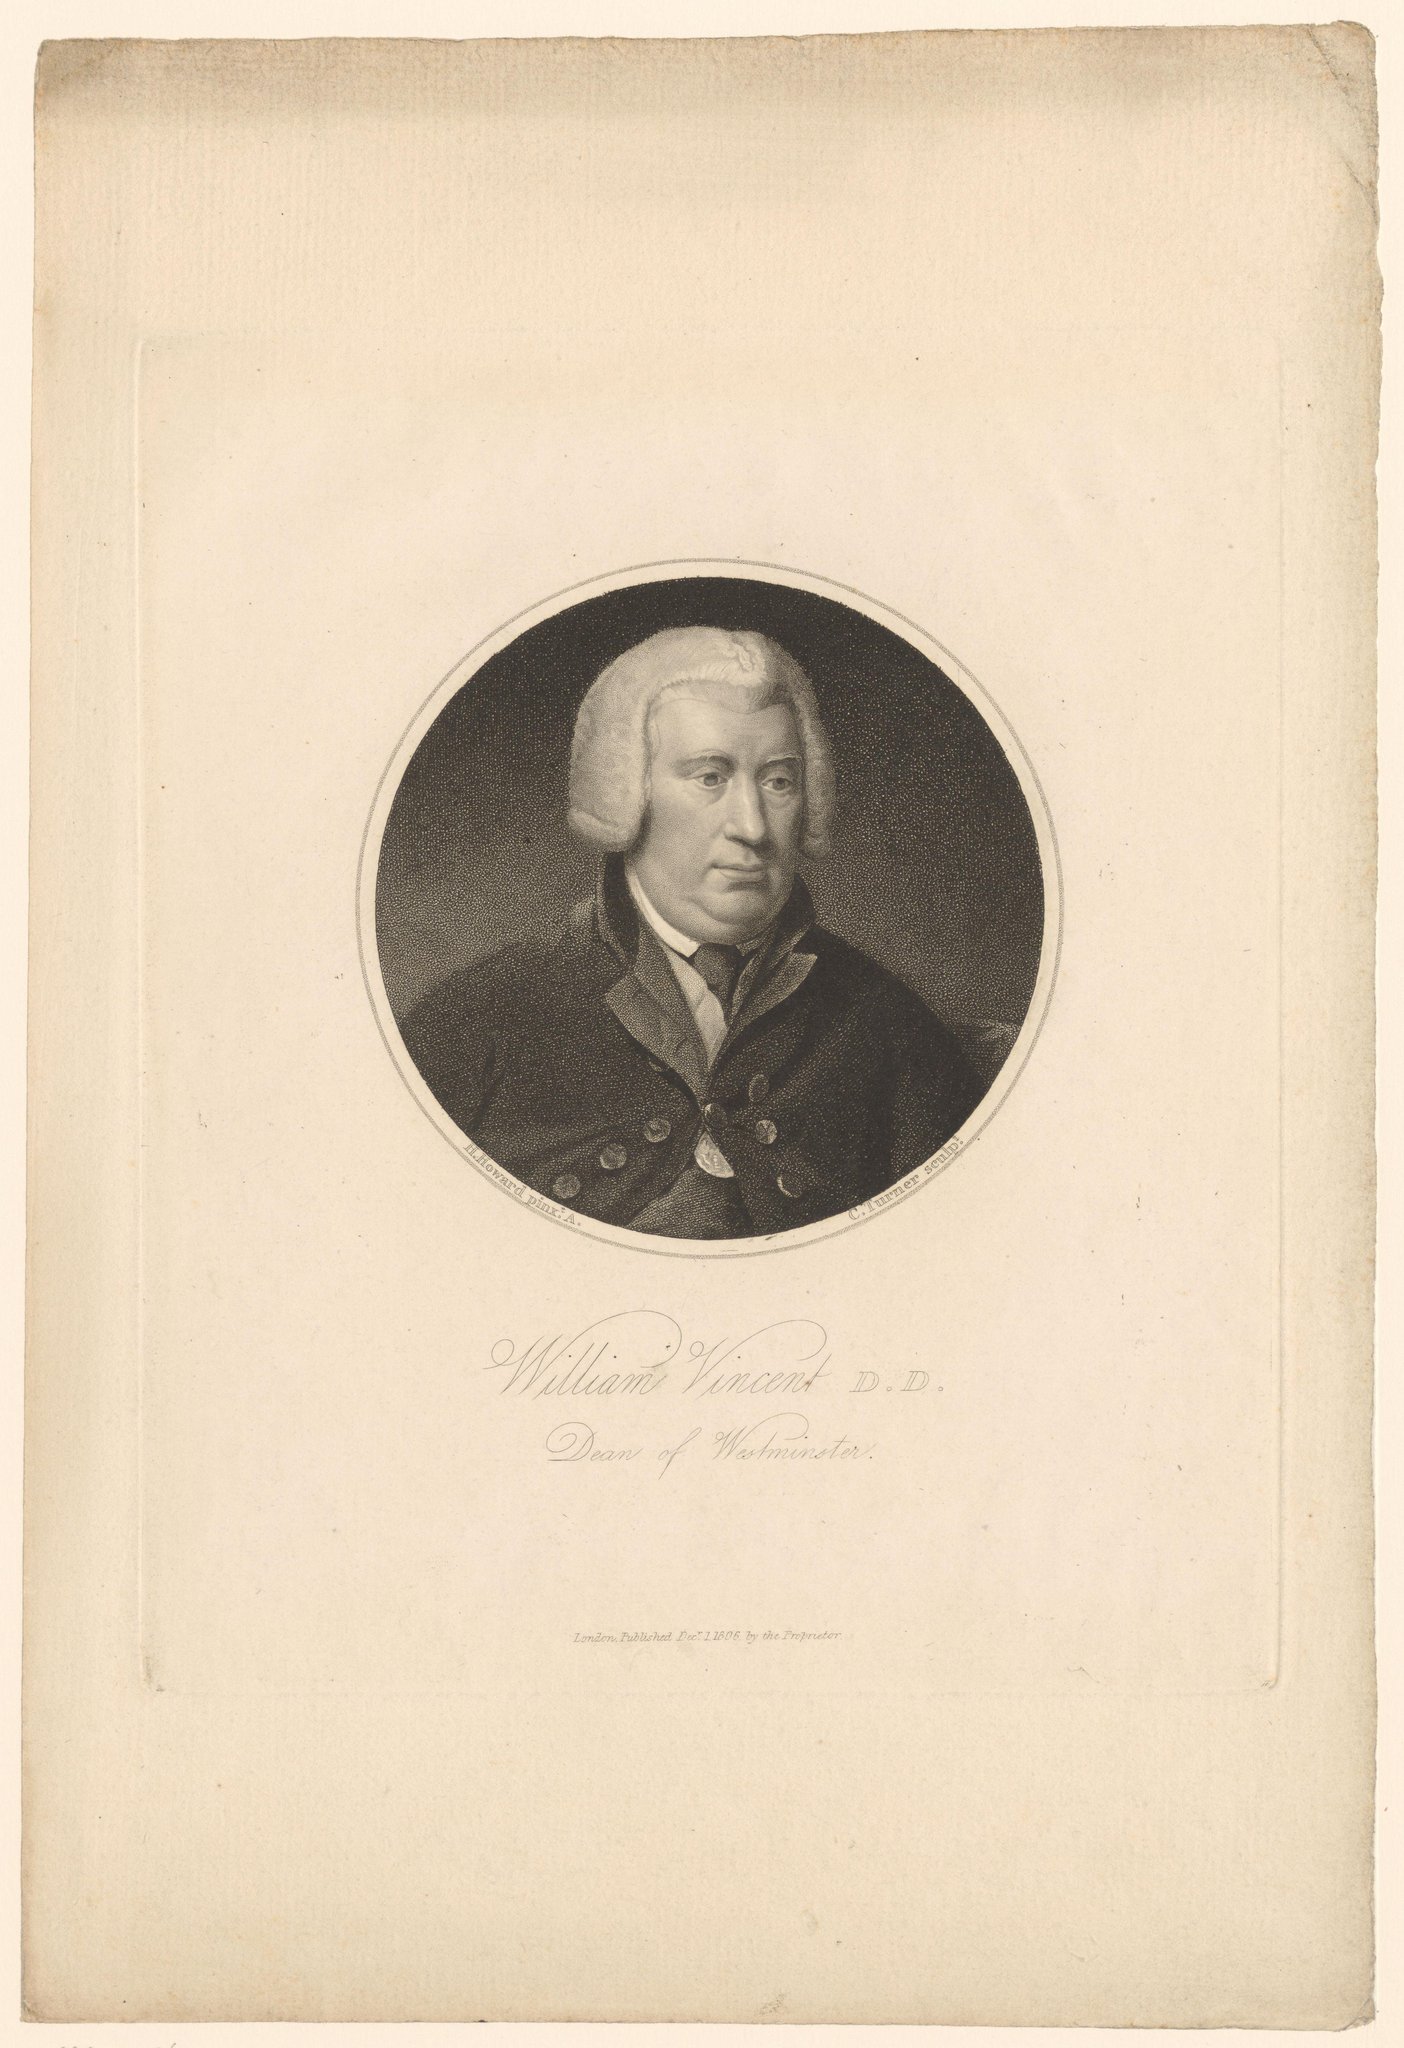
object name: print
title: William Vincent D.D. Dean of Westminster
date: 1806-1812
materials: paper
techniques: engraving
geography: london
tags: priest (roman catholic), historical persons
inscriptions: collector's mark: Lugt 2228